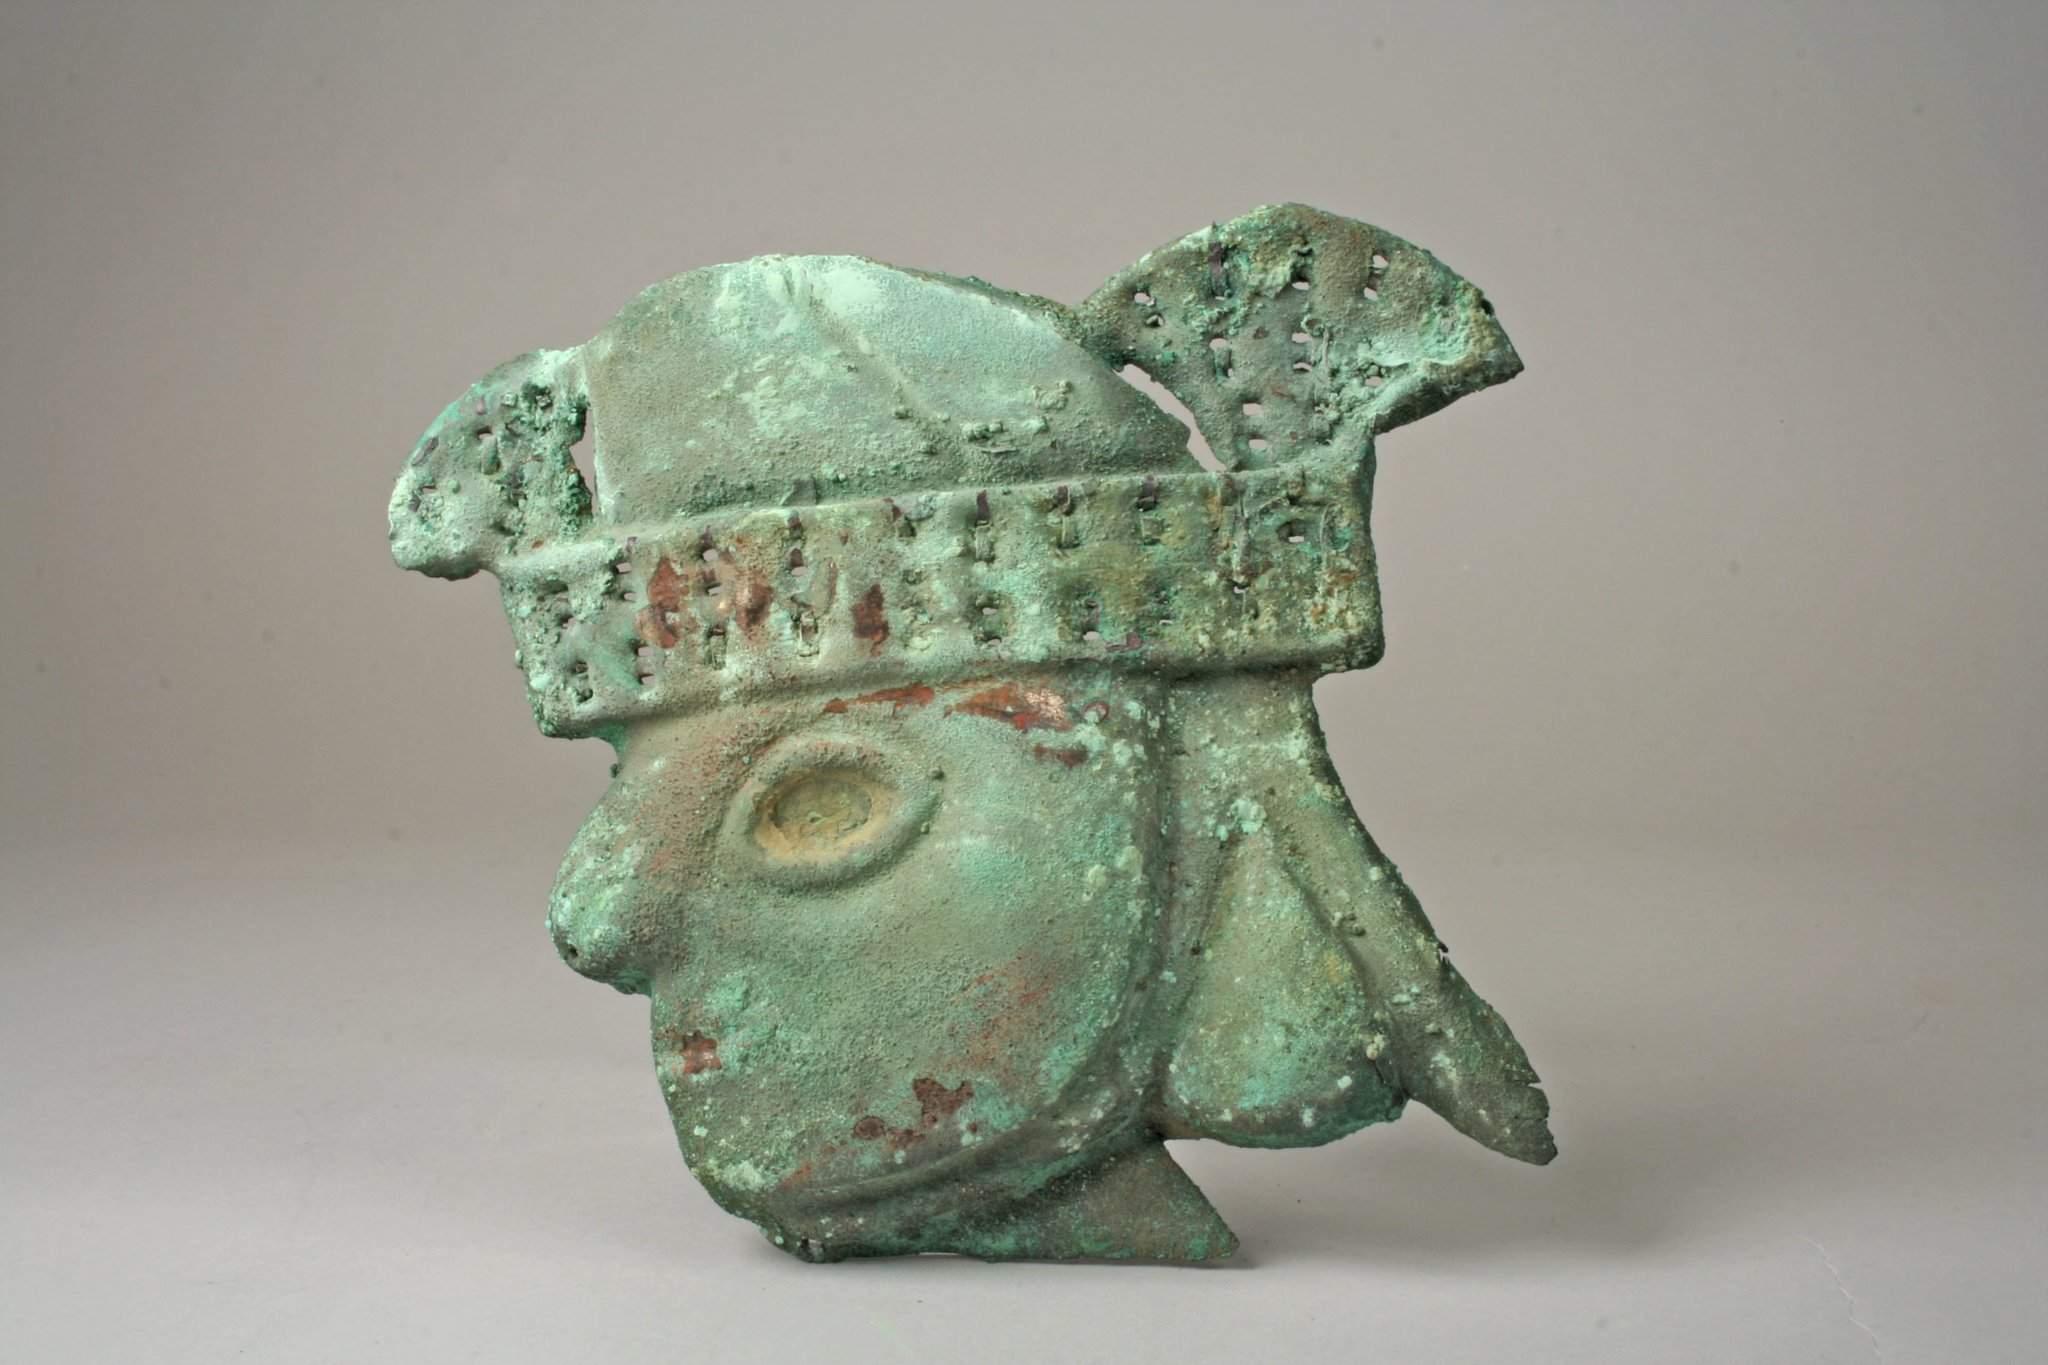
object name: ornament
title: Profile Face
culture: moche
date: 501-700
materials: metal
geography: peru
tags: faces,profiles